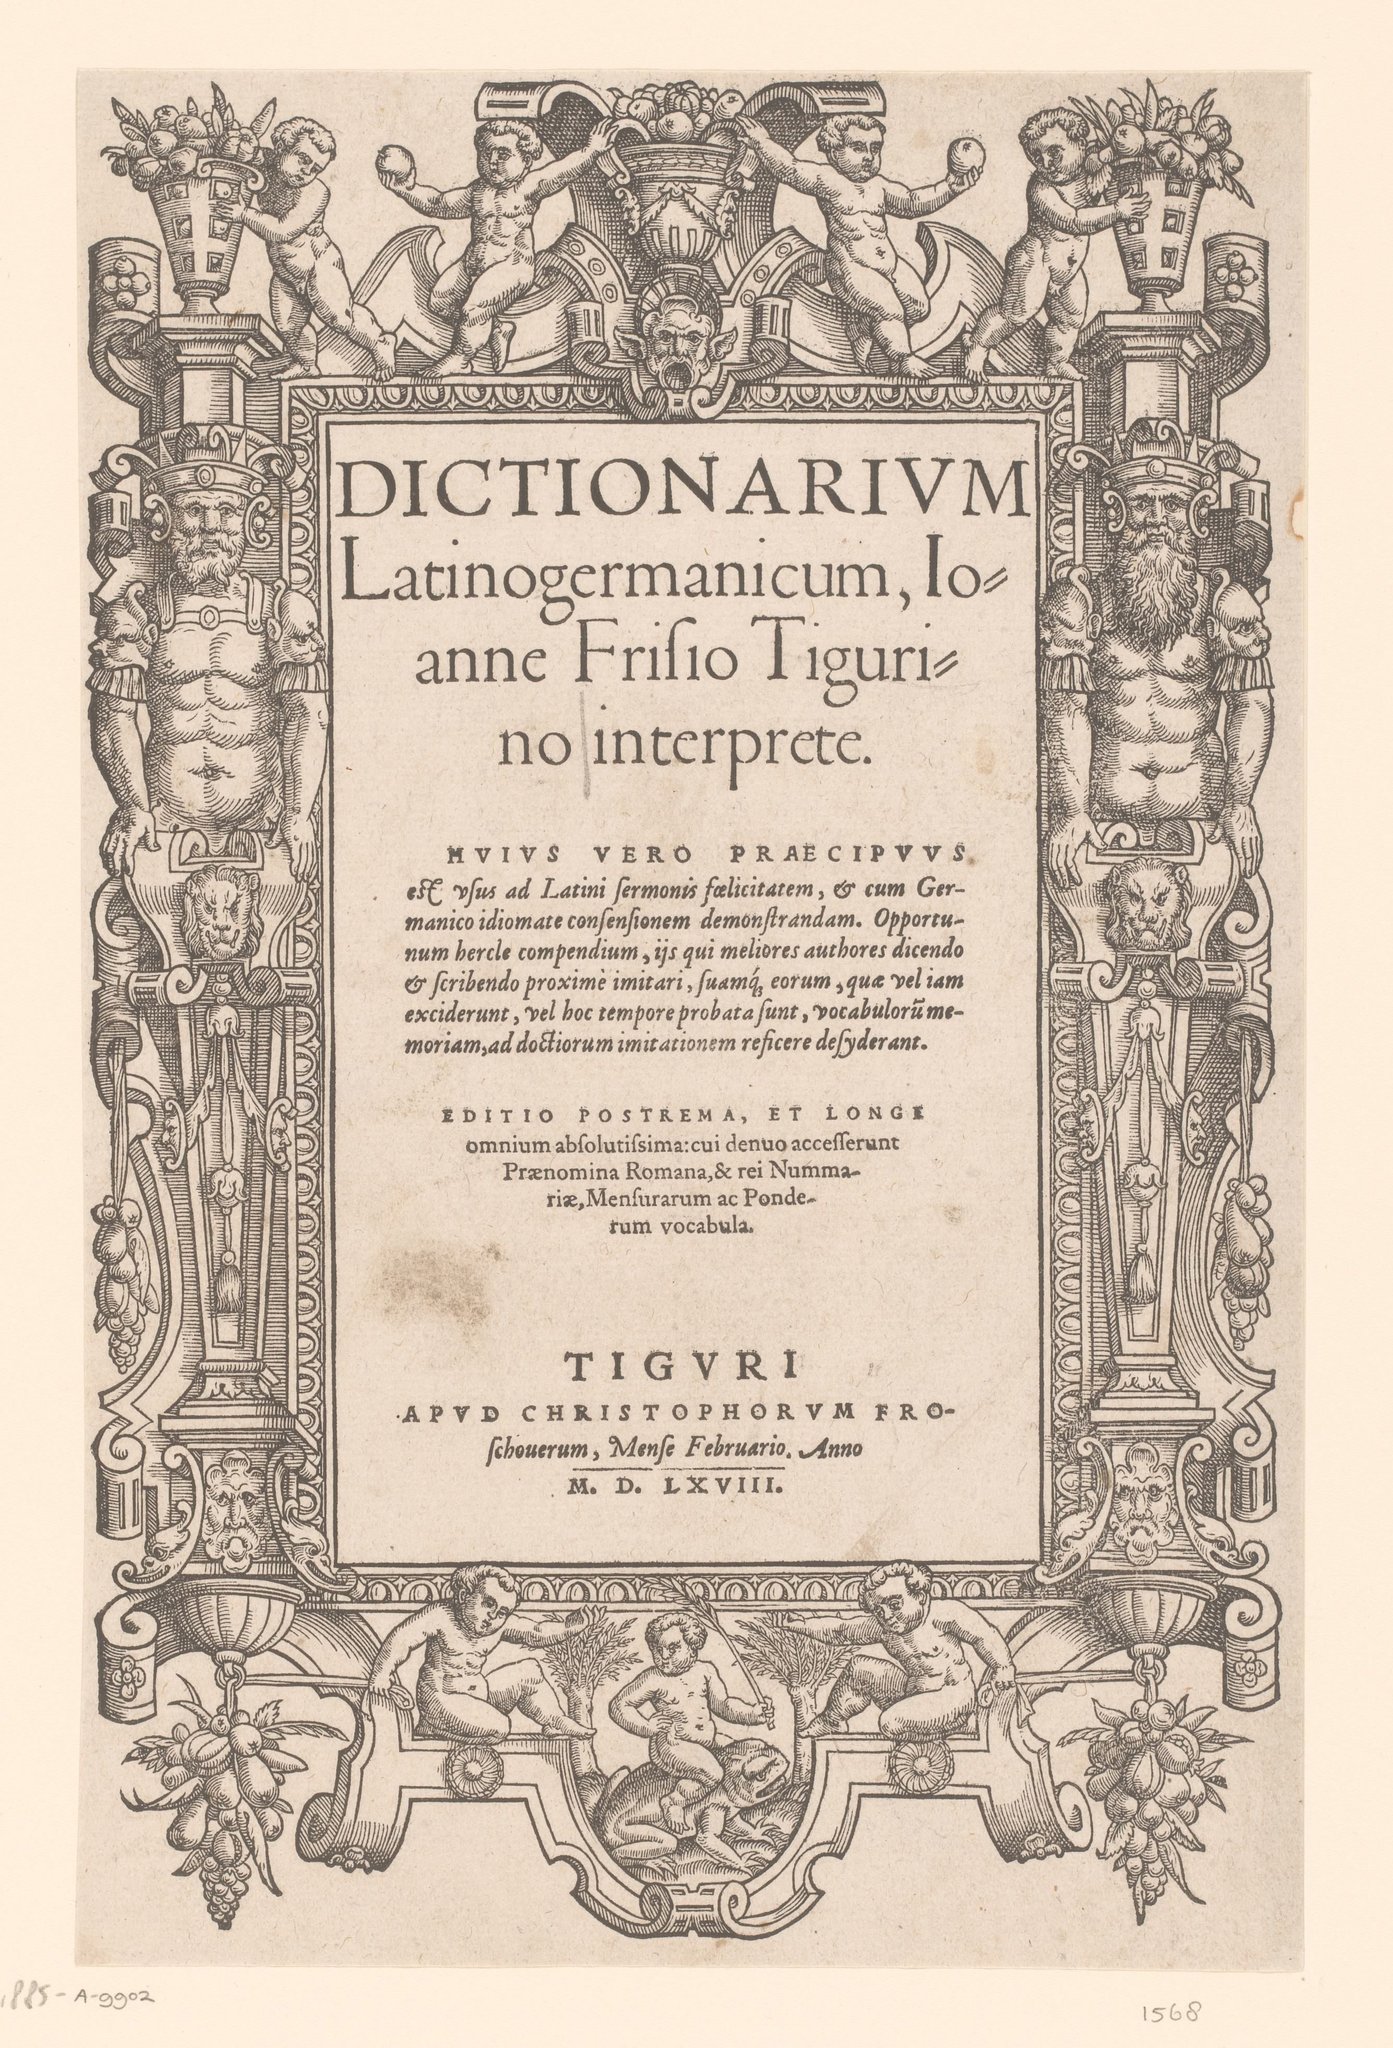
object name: print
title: Titelpagina voor: Johannes Frisius, Dictionarium Latinogermanicum, Ioanne Frisio Tigurino interprete, 1568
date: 1568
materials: paper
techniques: woodcut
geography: zurich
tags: anthropomorphic ornament, title-page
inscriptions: collector's mark: Lugt 2228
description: Titelpagina voor: Frisius, Johannes. Dictionarium Latinogermanicum, Ioanne Frisio Tigurino interprete. Zürich: Christoph Froschauer, 1568.